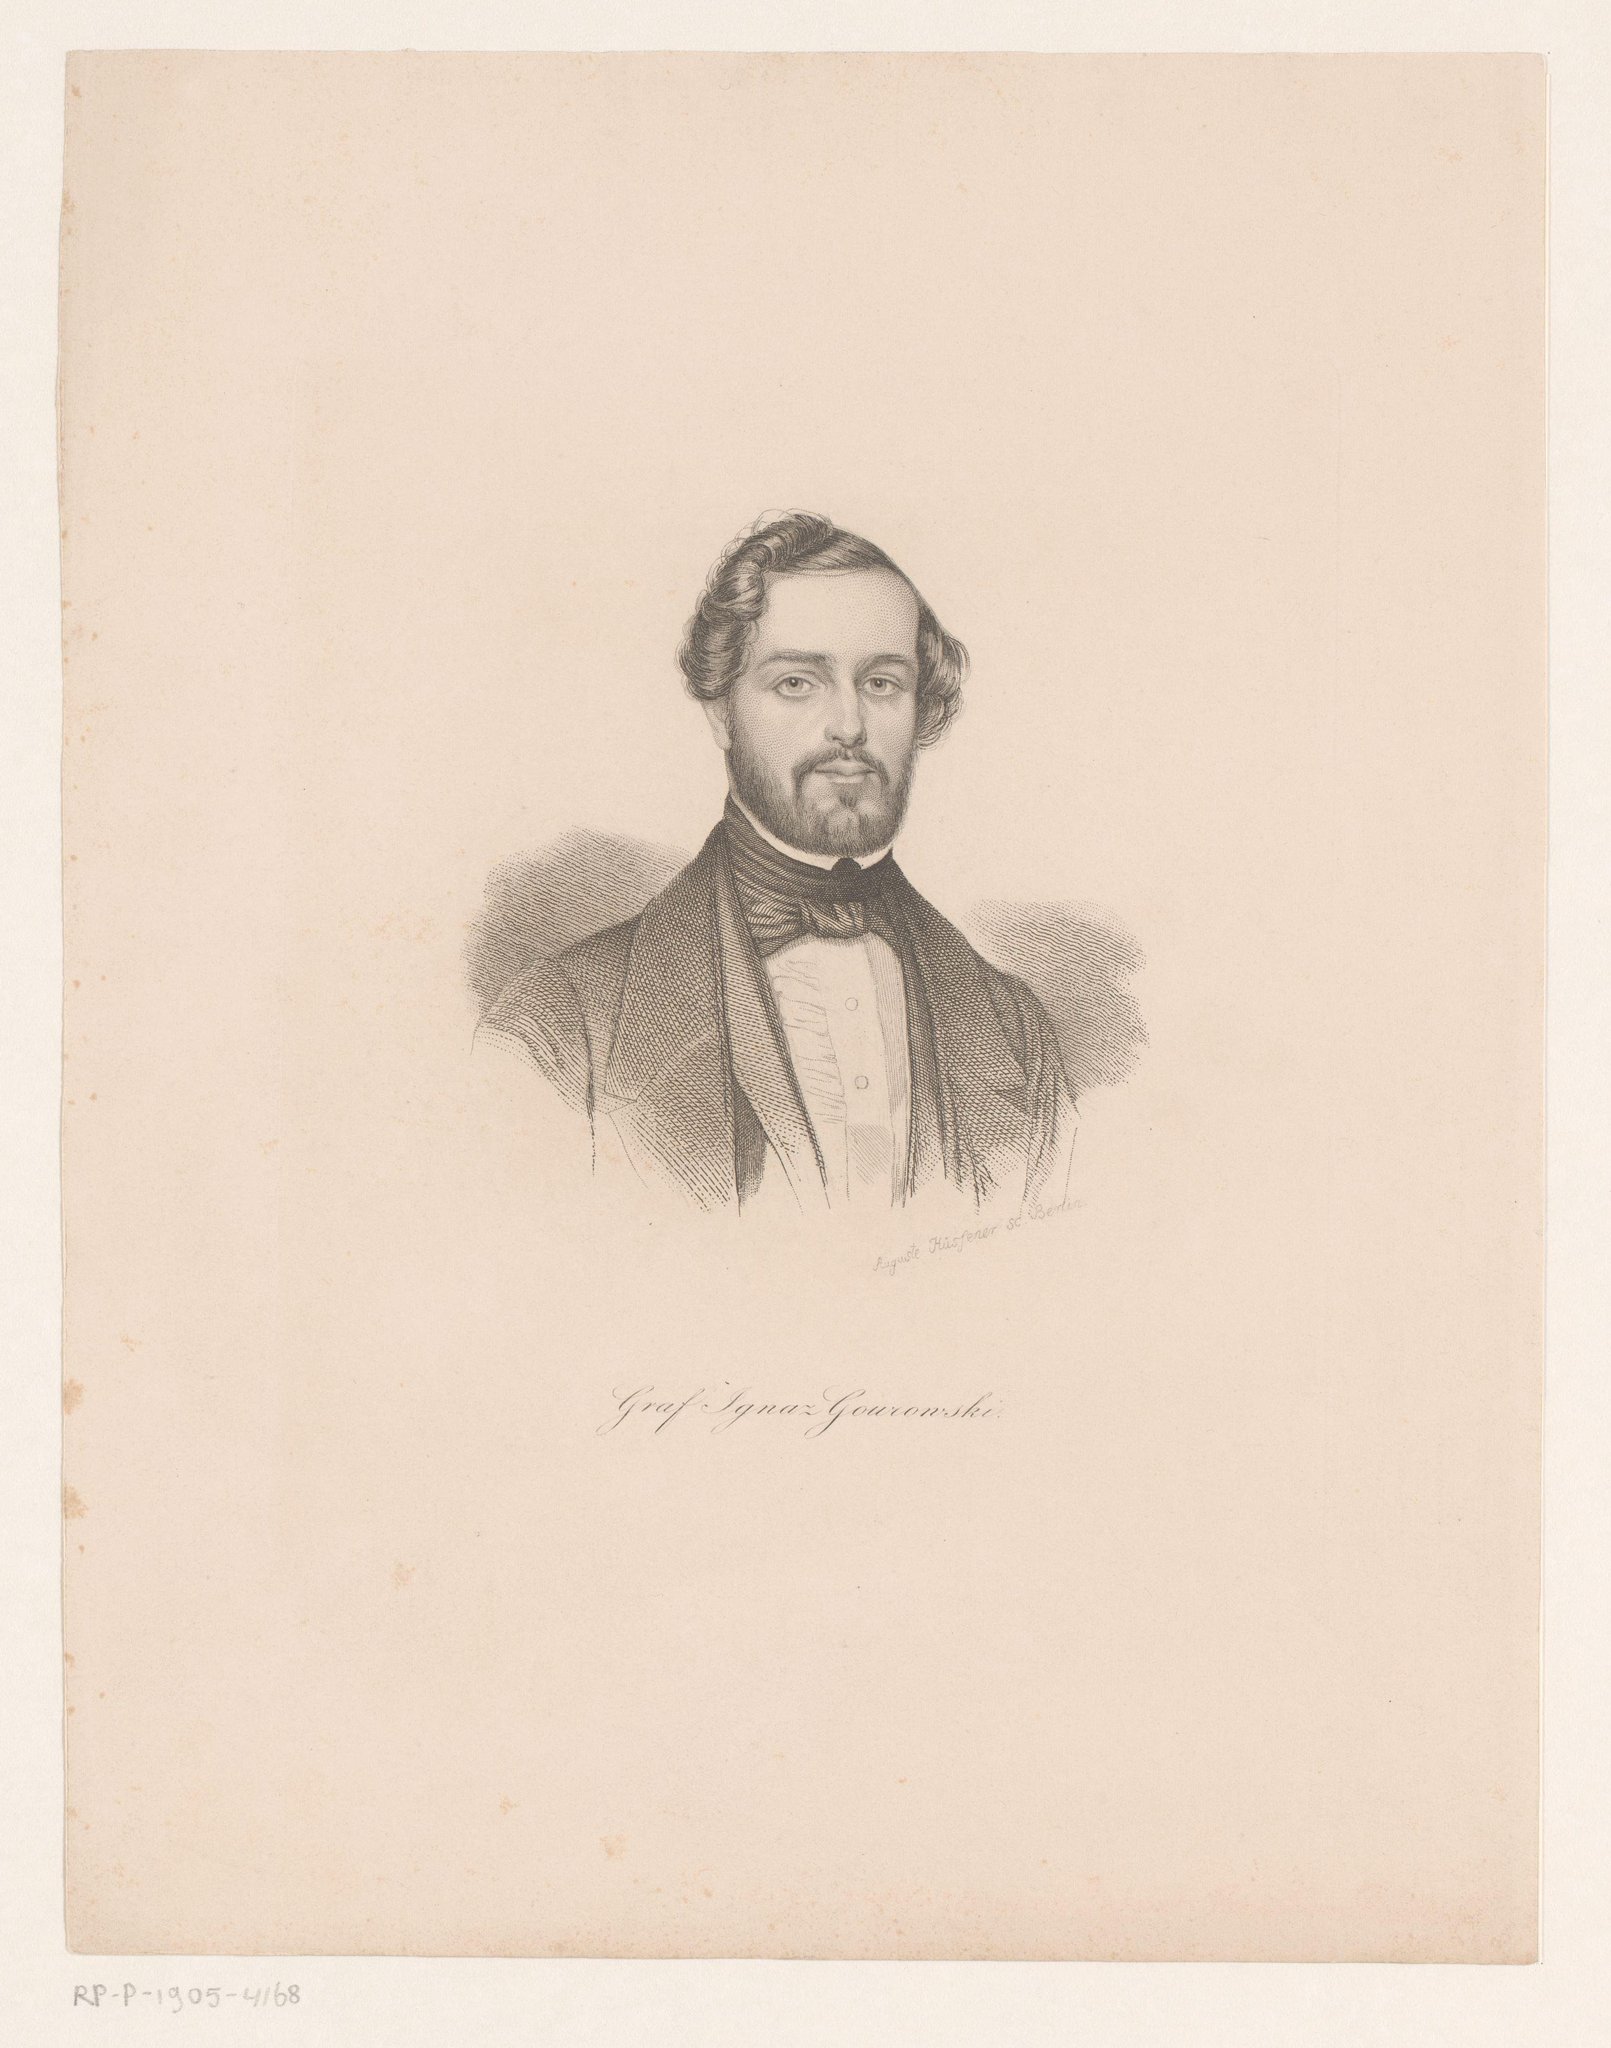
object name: print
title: Portret van Ignacy Gurowski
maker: auguste hüssener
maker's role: print maker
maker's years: 1789-1877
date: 1799-1877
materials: paper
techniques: etching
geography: berlin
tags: historical persons, portrait of a writer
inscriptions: collector's mark: Lugt 2228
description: Portret van graaf Gurowski (Ignaz Gouronski).